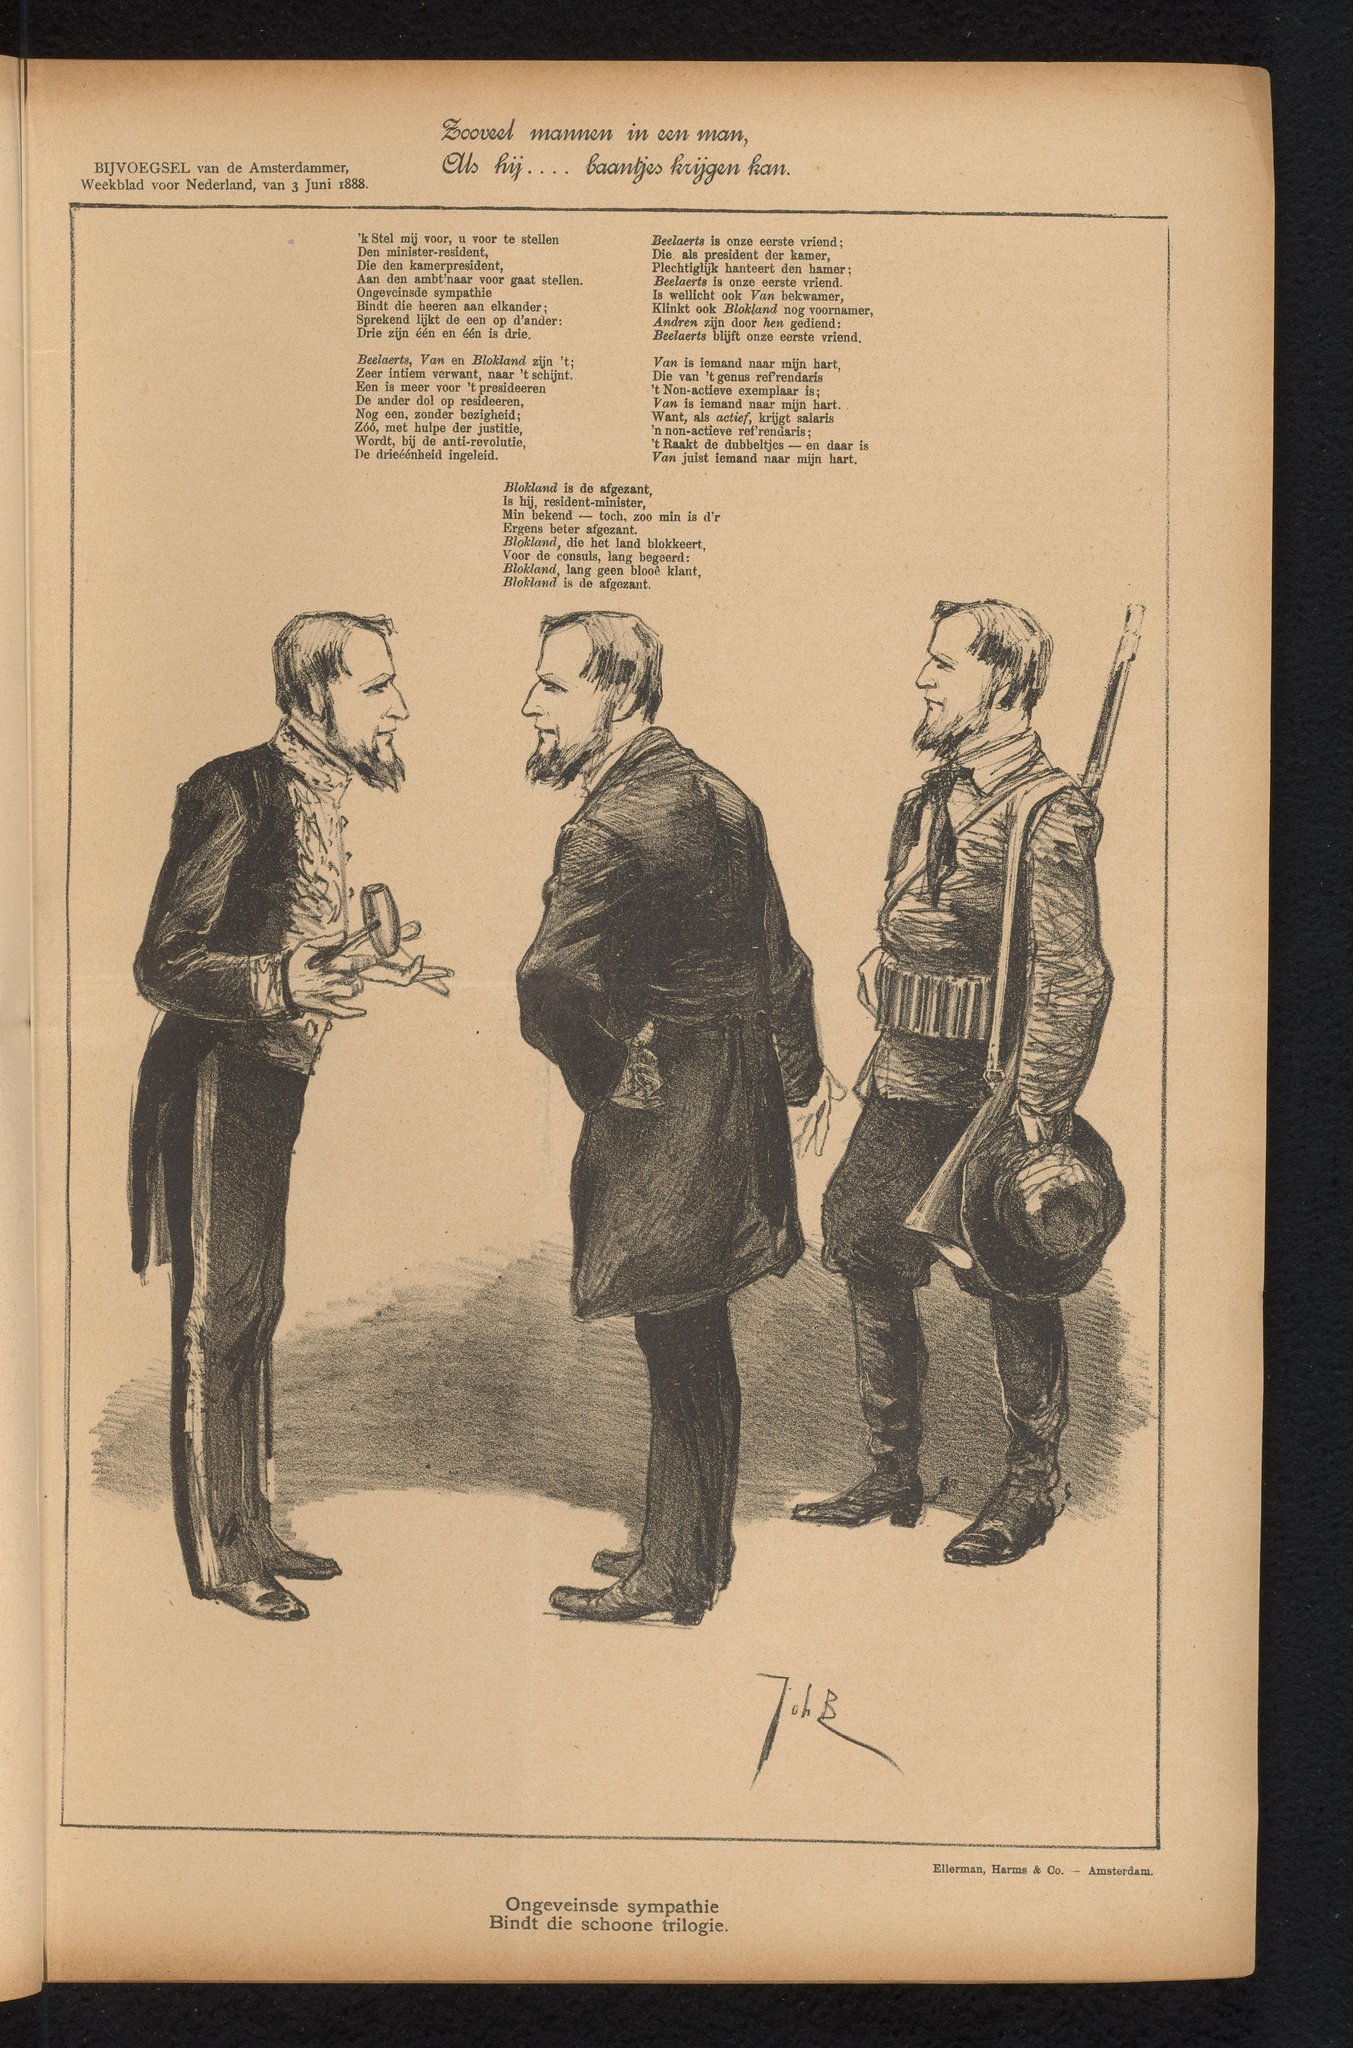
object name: cartoon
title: Zooveel mannen in een man, Als hij ... baantjes krijgen kan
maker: johan braakensiek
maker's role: draughtsman, print maker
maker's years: 1858-1940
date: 1888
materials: paper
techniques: lithograph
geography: netherlands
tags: rotterdam, the hague, politician, e.g. party leader, lower house, parliament, chamber, political caricatures and satires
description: Gerard Jacob Theodoor Beelaerts van Blokland in zijn drie functies als voorzitter van de Tweede Kamer, gezant van de Zuid-Afrikaansche Republiek (Transvaal) en ambtenaar op het Ministerie van Justitie.